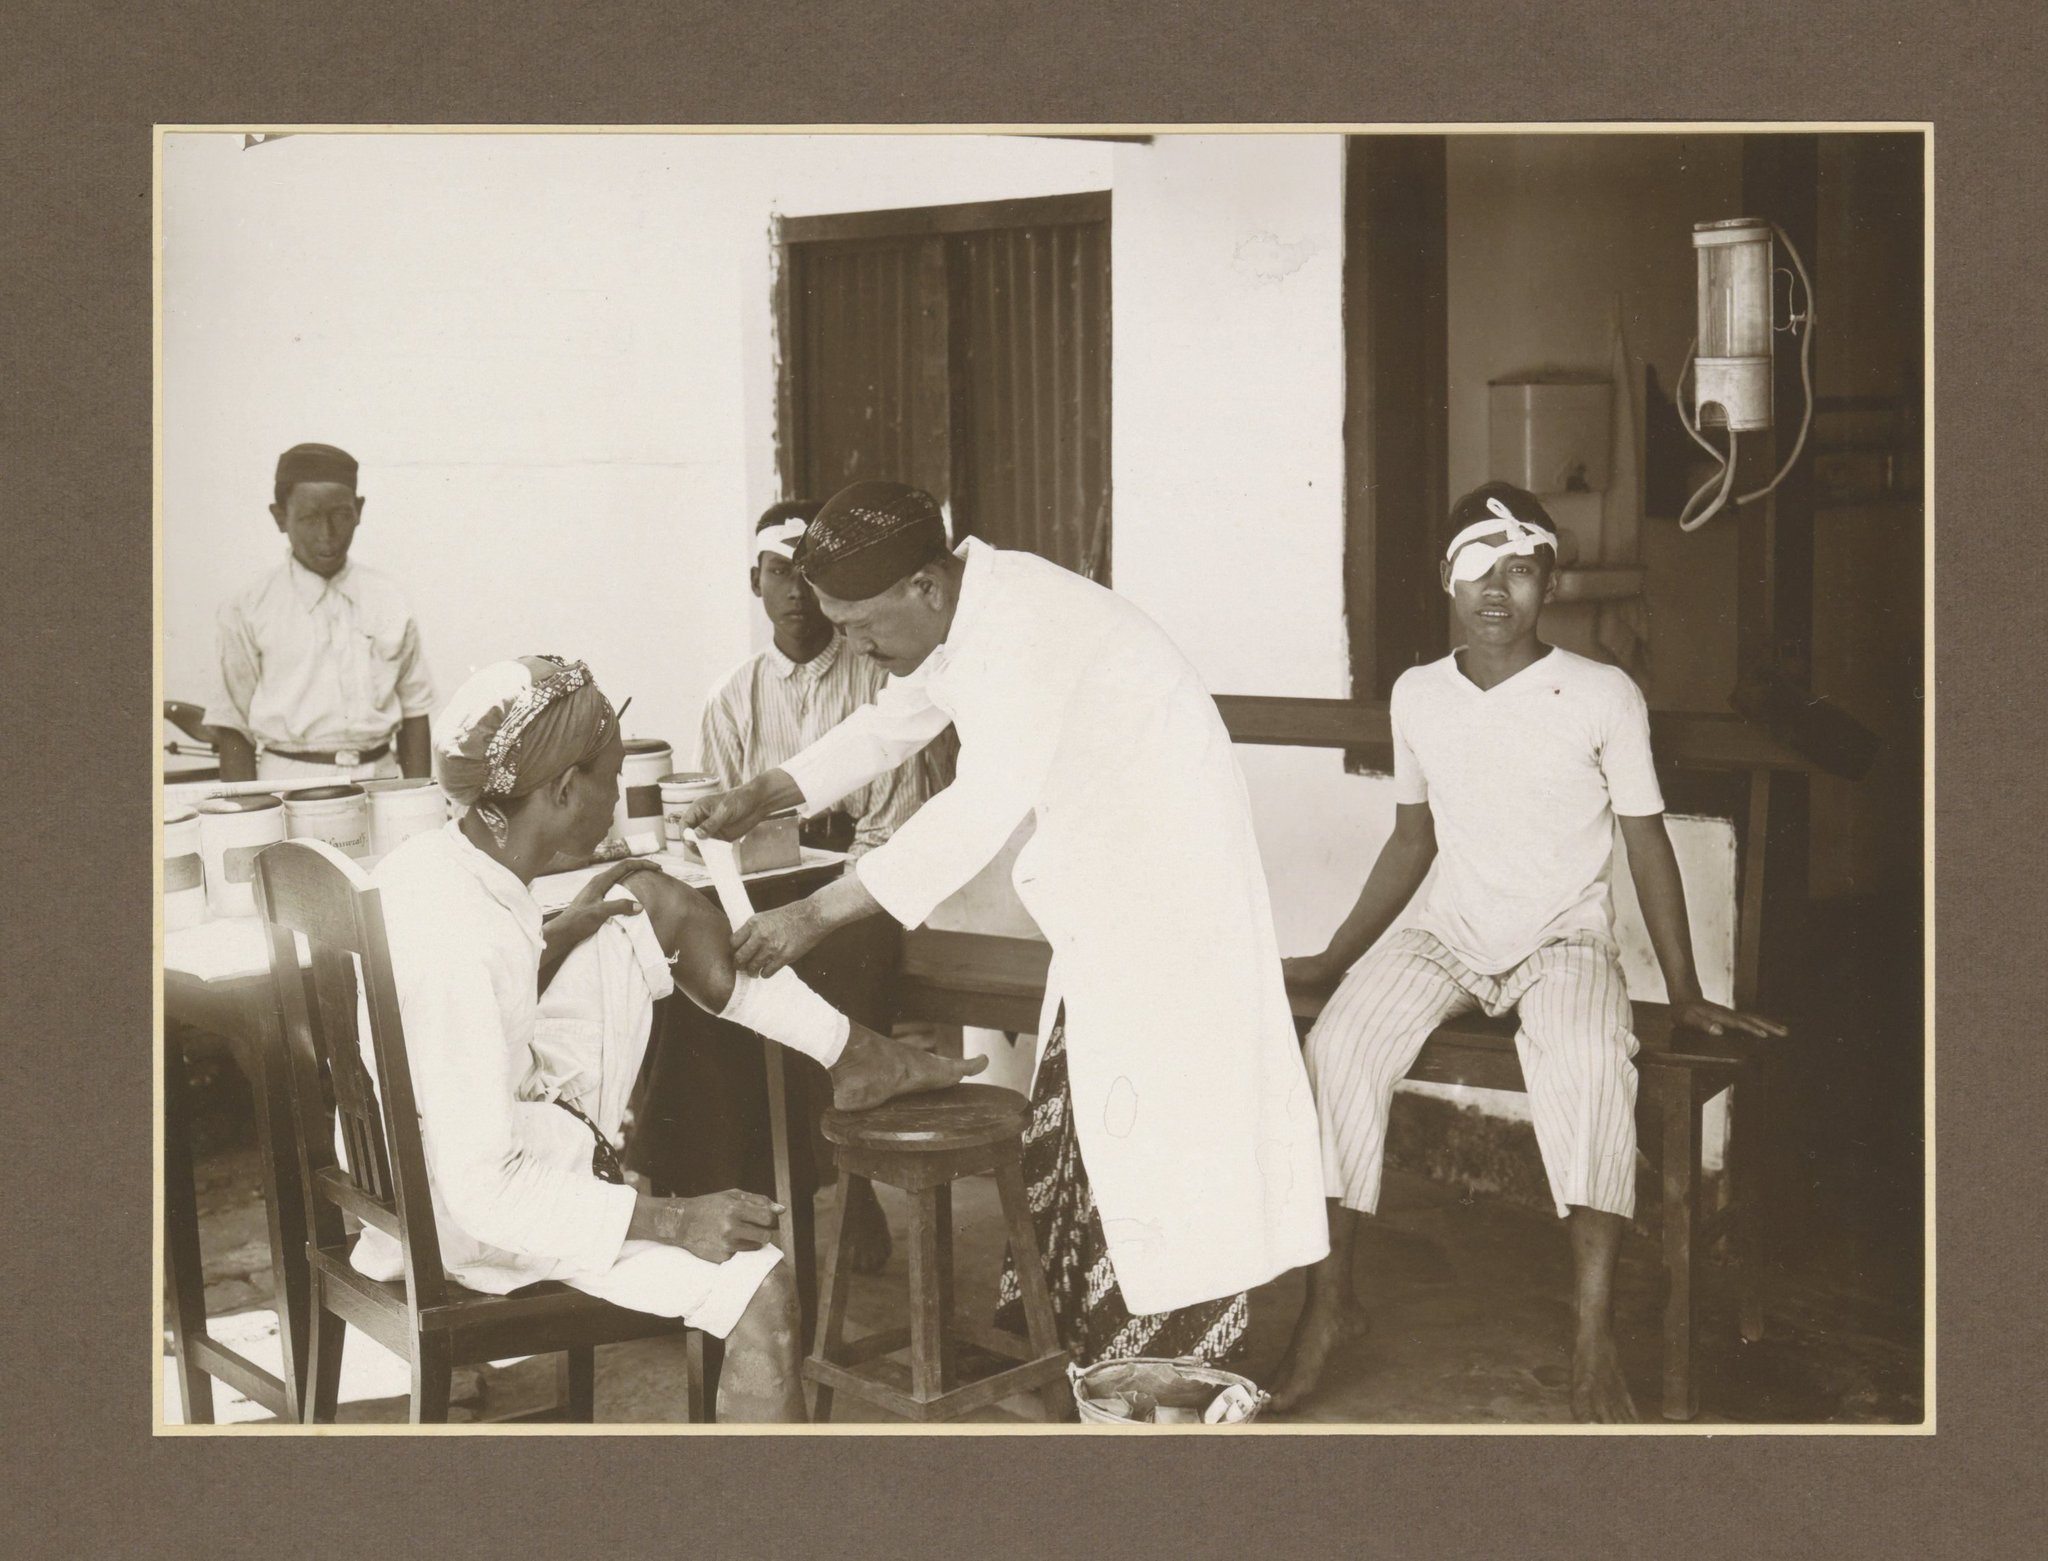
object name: album leaf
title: Mantriverpleger en patiënten in de polikliniek van suikerfabriek Boedoeran in Sidoarjo op Java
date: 1925-1930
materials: cardboard, paper, photographic support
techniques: gelatin silver print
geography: sidoarjo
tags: plantation, physician, doctor, hospital, patient, sick person, plants and herbs: sugarcane, sugar, dutch east indies, the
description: Onderdeel van Fotoalbum met opnames van vier suikerfabrieken op Java.